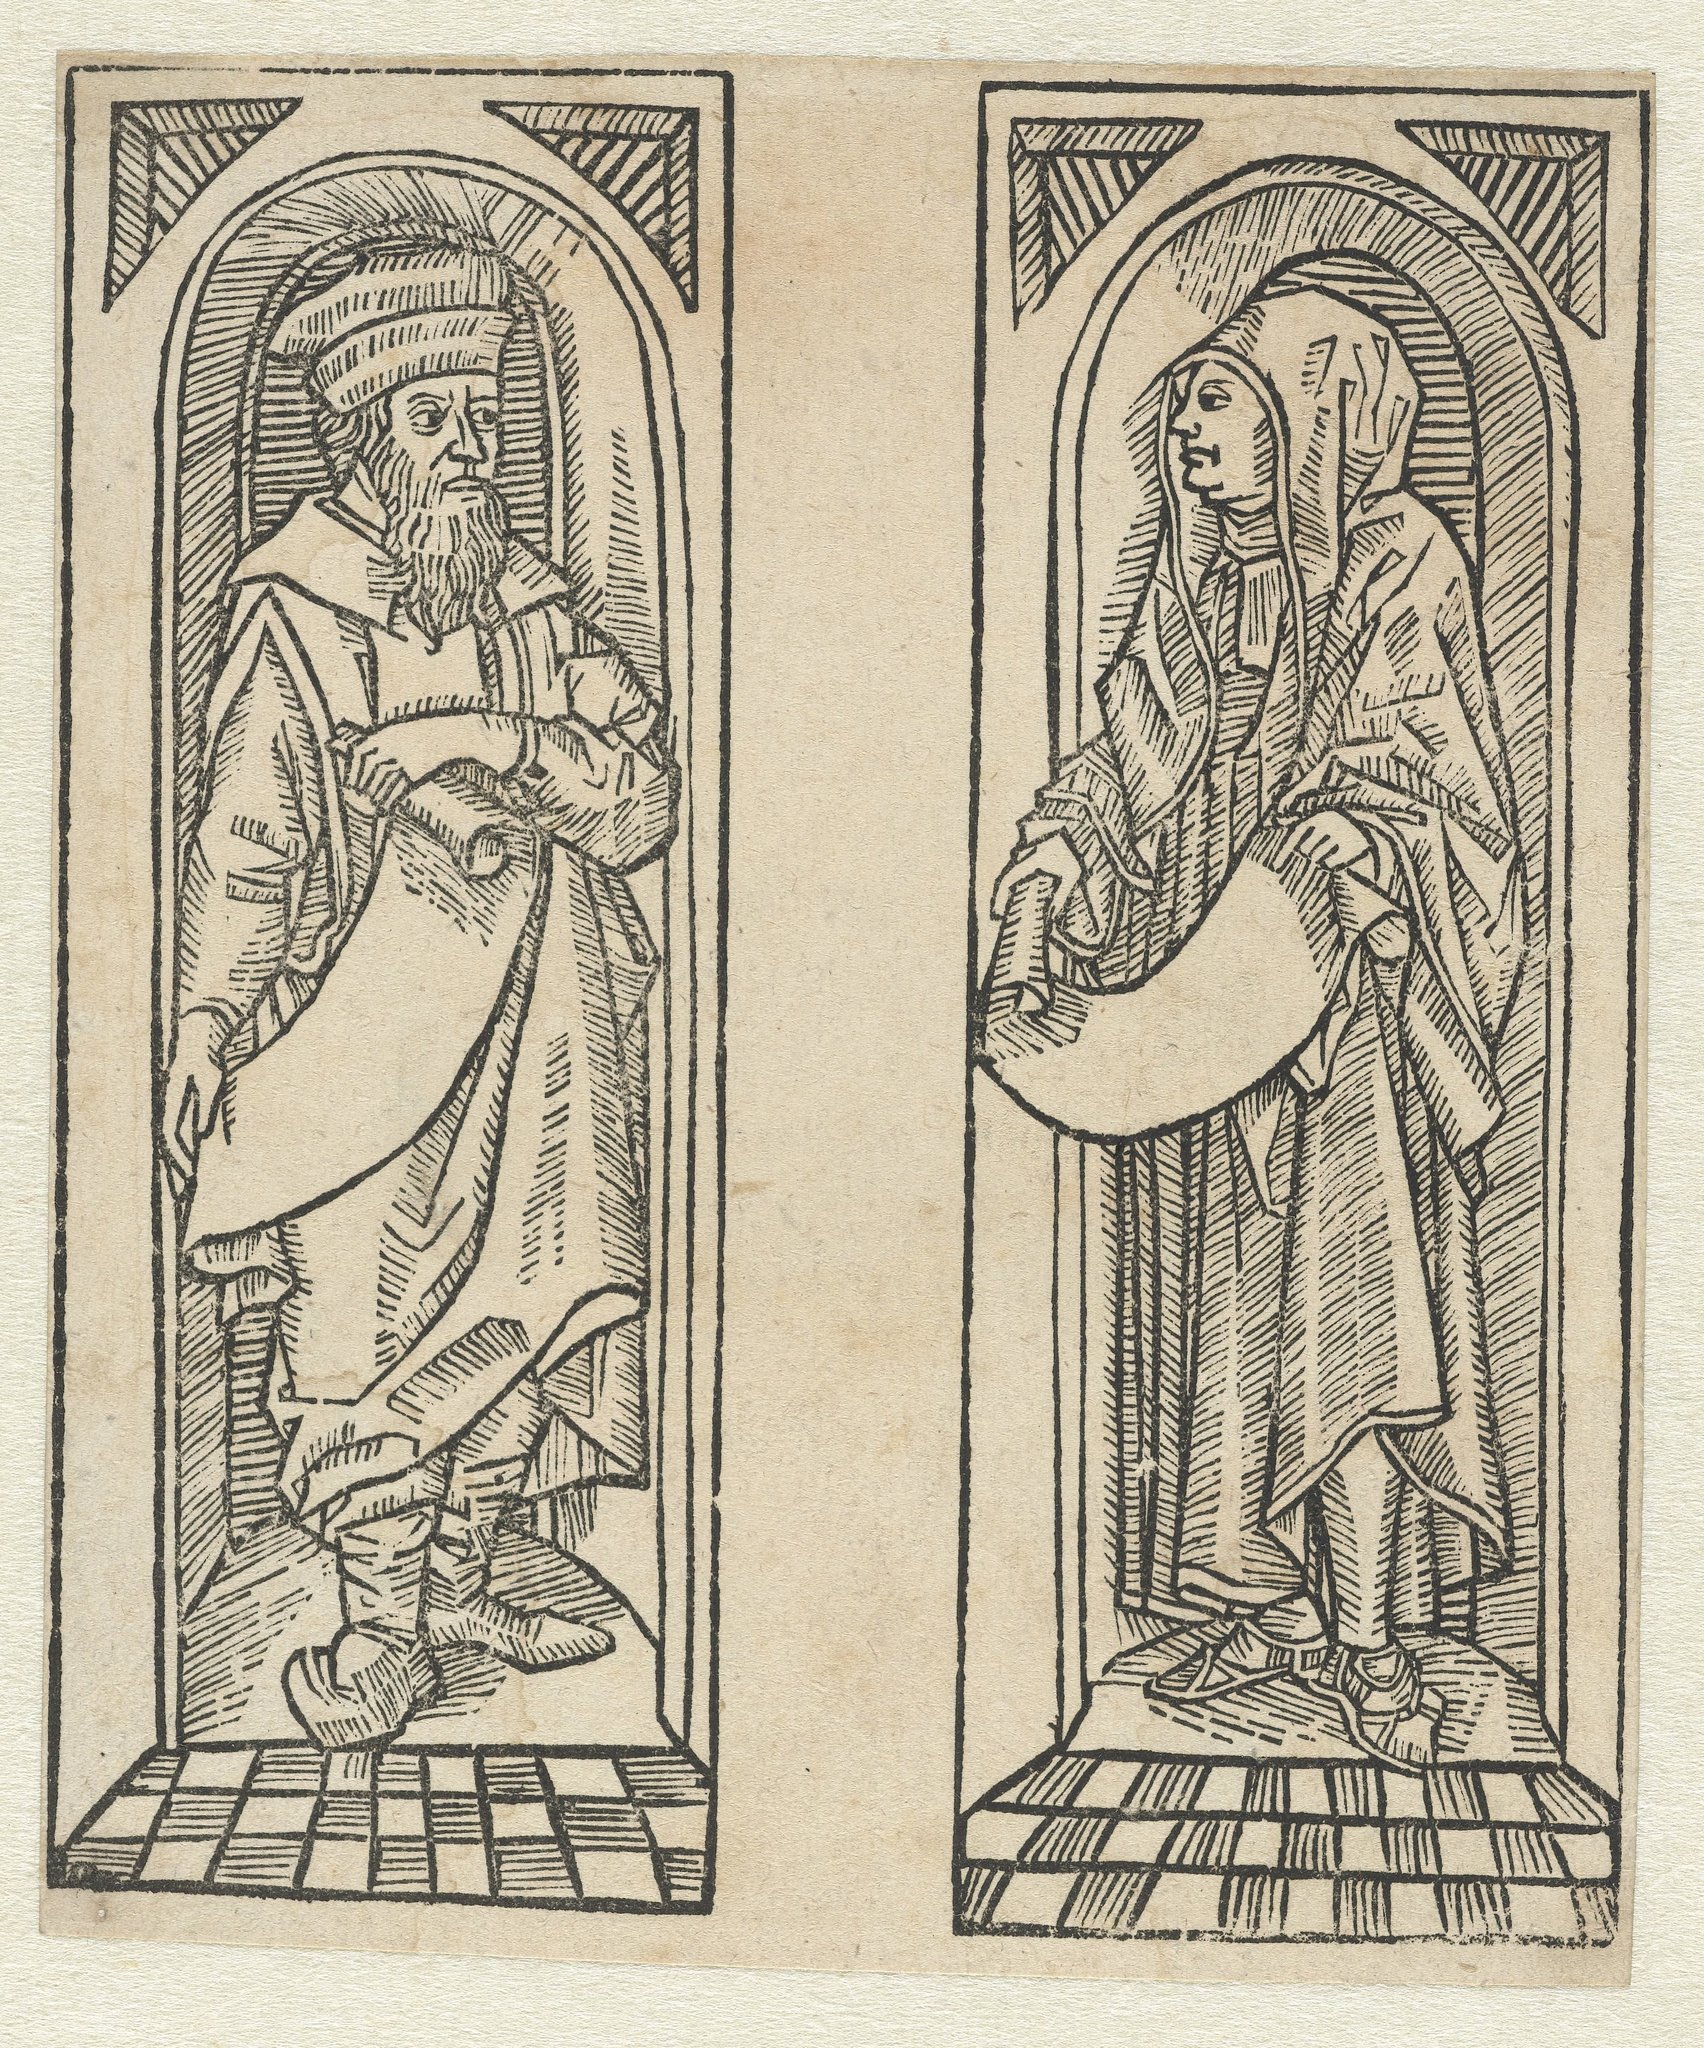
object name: print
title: Vierde profeet en een profetes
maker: Anonymous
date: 1470-1482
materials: paper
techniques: woodcut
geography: germany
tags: (single) prophet, unspecified, sibyls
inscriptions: collector's mark: Lugt 2233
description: Houtsnede gebruikt als boekillustratie in Spruch von der Pestilenz, uitgegeven door Hans Foltz te Neurenberg in 1482.